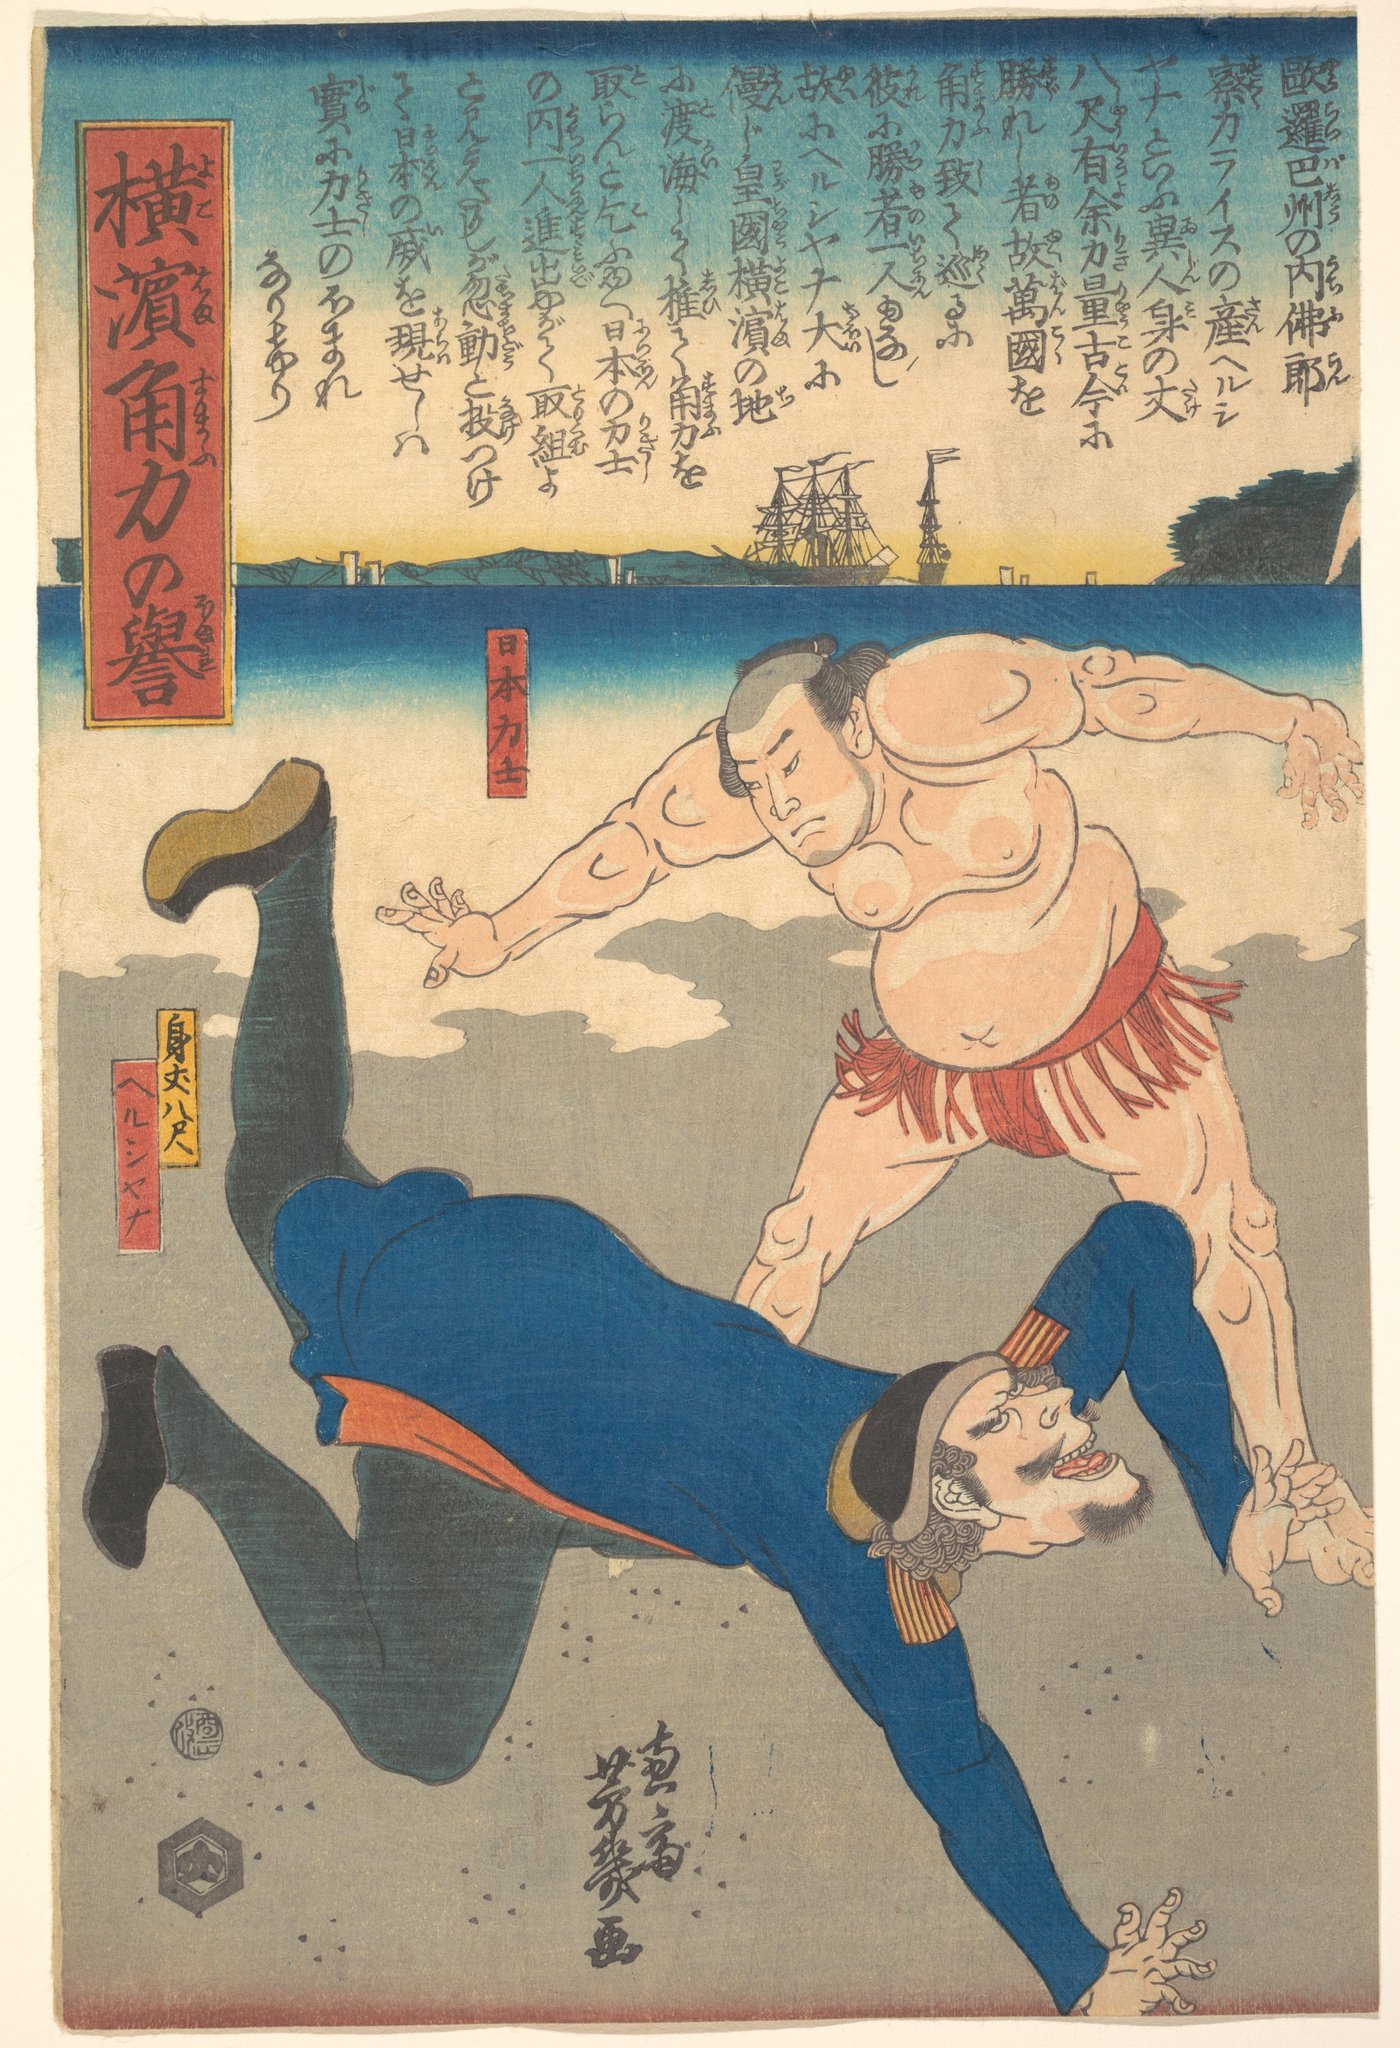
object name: print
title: Sumo Wrestler Tossing a Foreigner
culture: japanese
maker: utagawa yoshiiku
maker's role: artist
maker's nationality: japanese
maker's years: 1833-1904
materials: ink, paper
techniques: woodblock print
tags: men